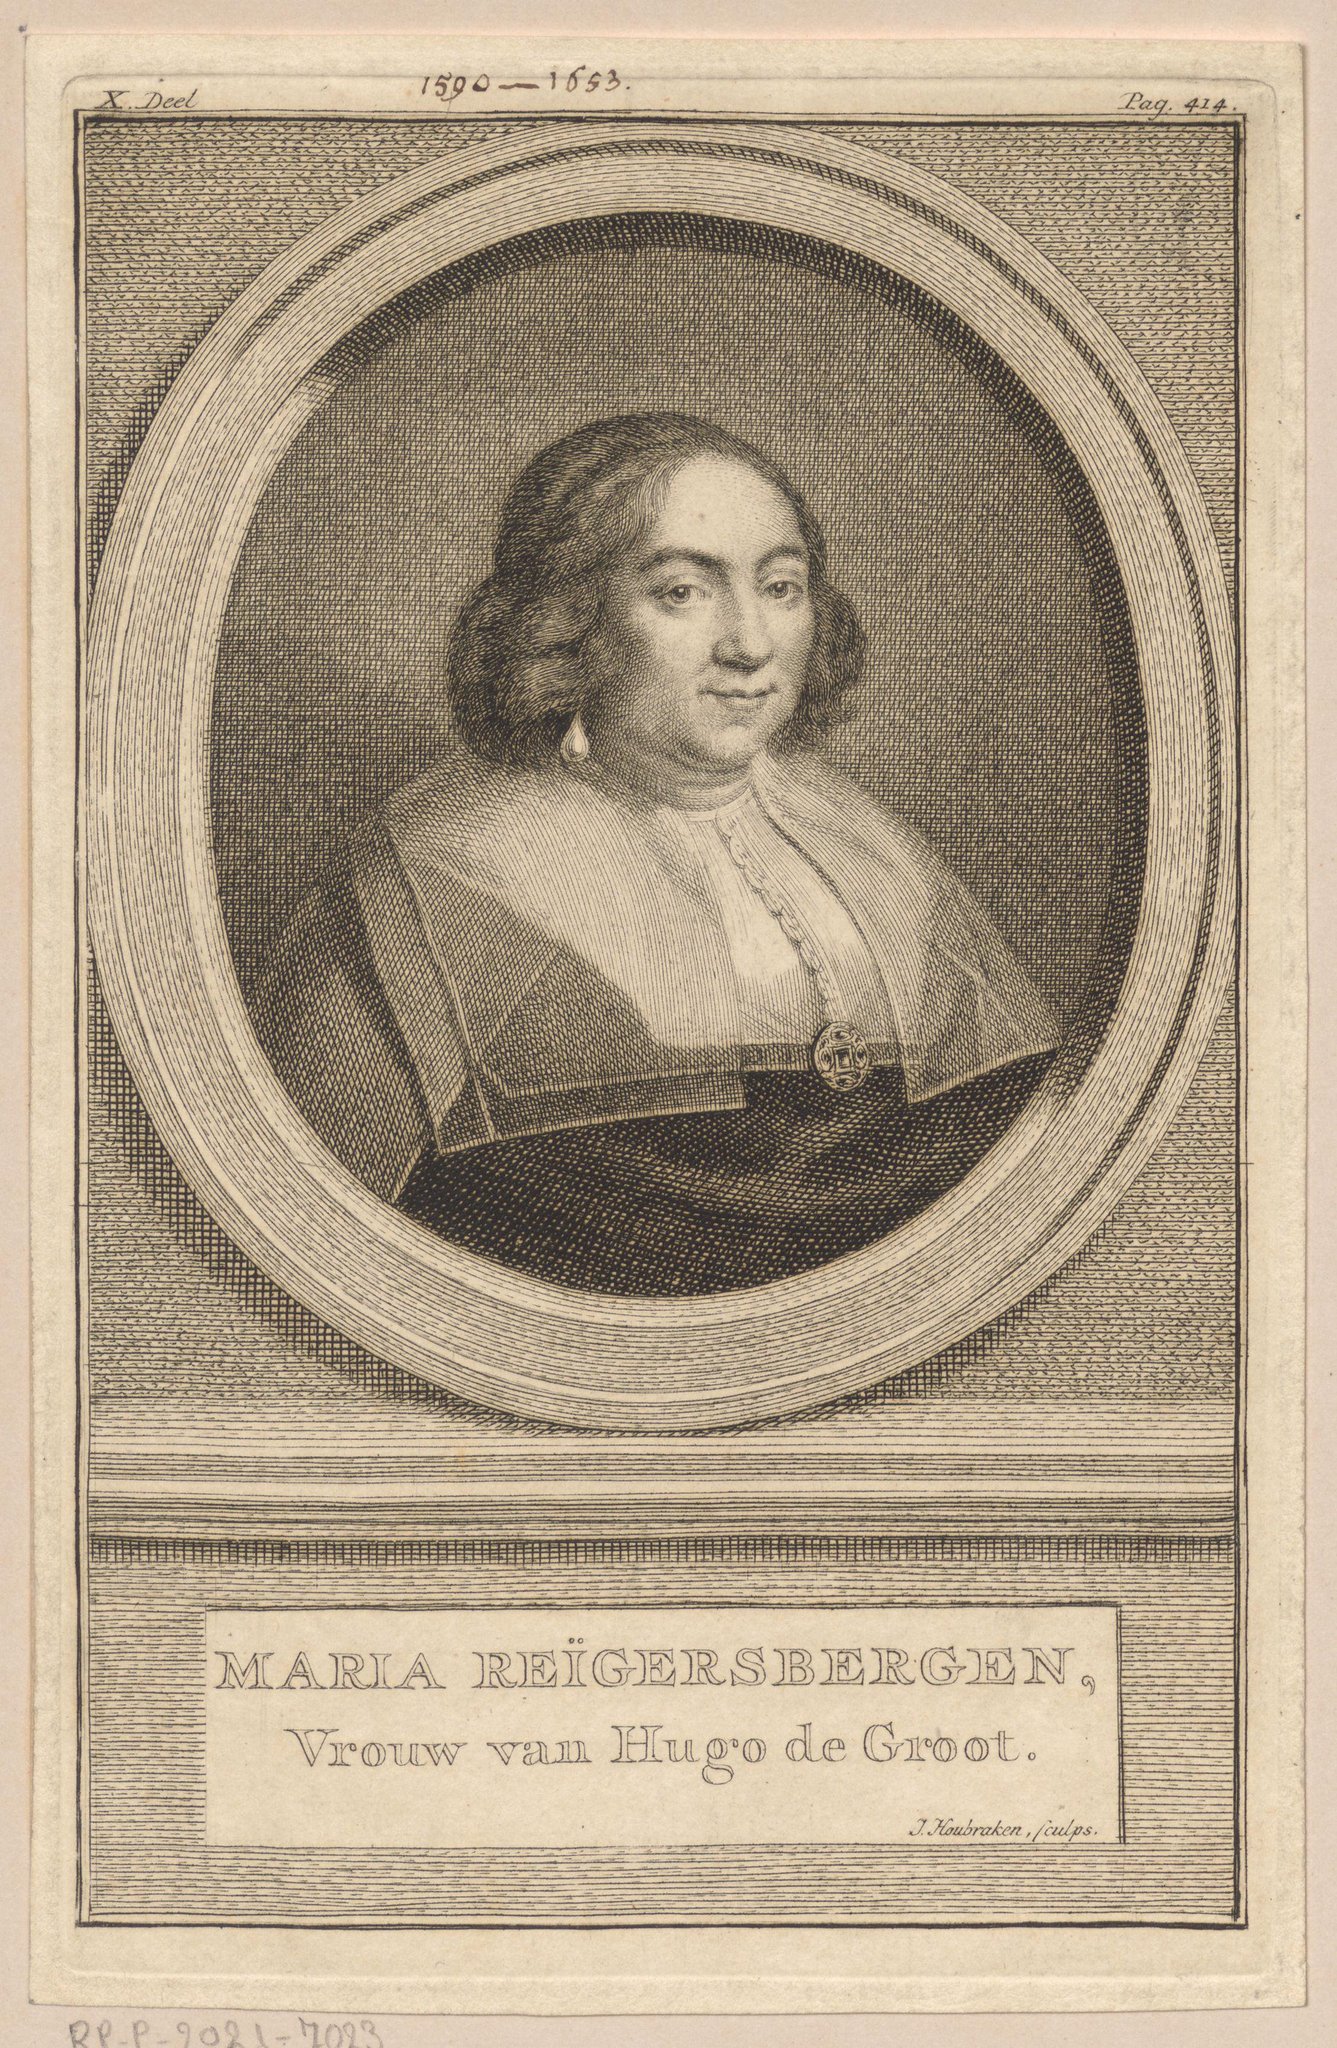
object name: print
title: Portret van Maria van Reigersberch (1589-1653)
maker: jacob houbraken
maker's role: draughtsman, print maker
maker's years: 1698-1780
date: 1754-1793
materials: paper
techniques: engraving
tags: historical persons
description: Prent mogelijk uit: Wagenaar, Jan. Vaderlandsche historie: vervattende de geschiedenissen der nu Vereenigde Nederlanden (...). Amsterdam: Isaak Tirion, 1754, dl. 10. Of uit een latere publicatie (1761, 1793). Prent zonder nummering gebruikt in een latere publicatie (1785).